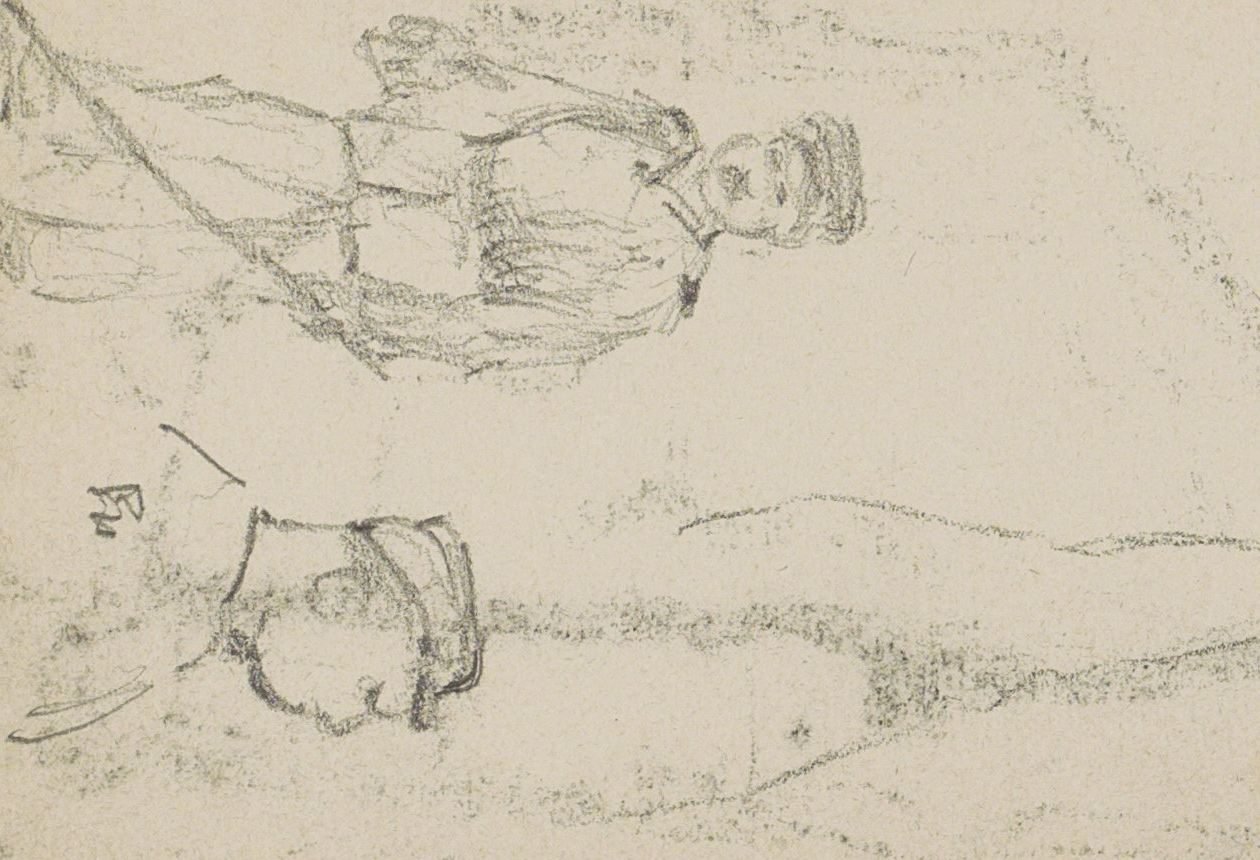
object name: sketchbook leaf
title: Man met een pet en wandelstok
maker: willem cornelis rip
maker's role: draughtsman, painter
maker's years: 1856-1922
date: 1896-1897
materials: paper, pencil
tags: standing figure, walking-stick, staff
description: Blad 13 verso uit een schetsboek met 44 bladen.